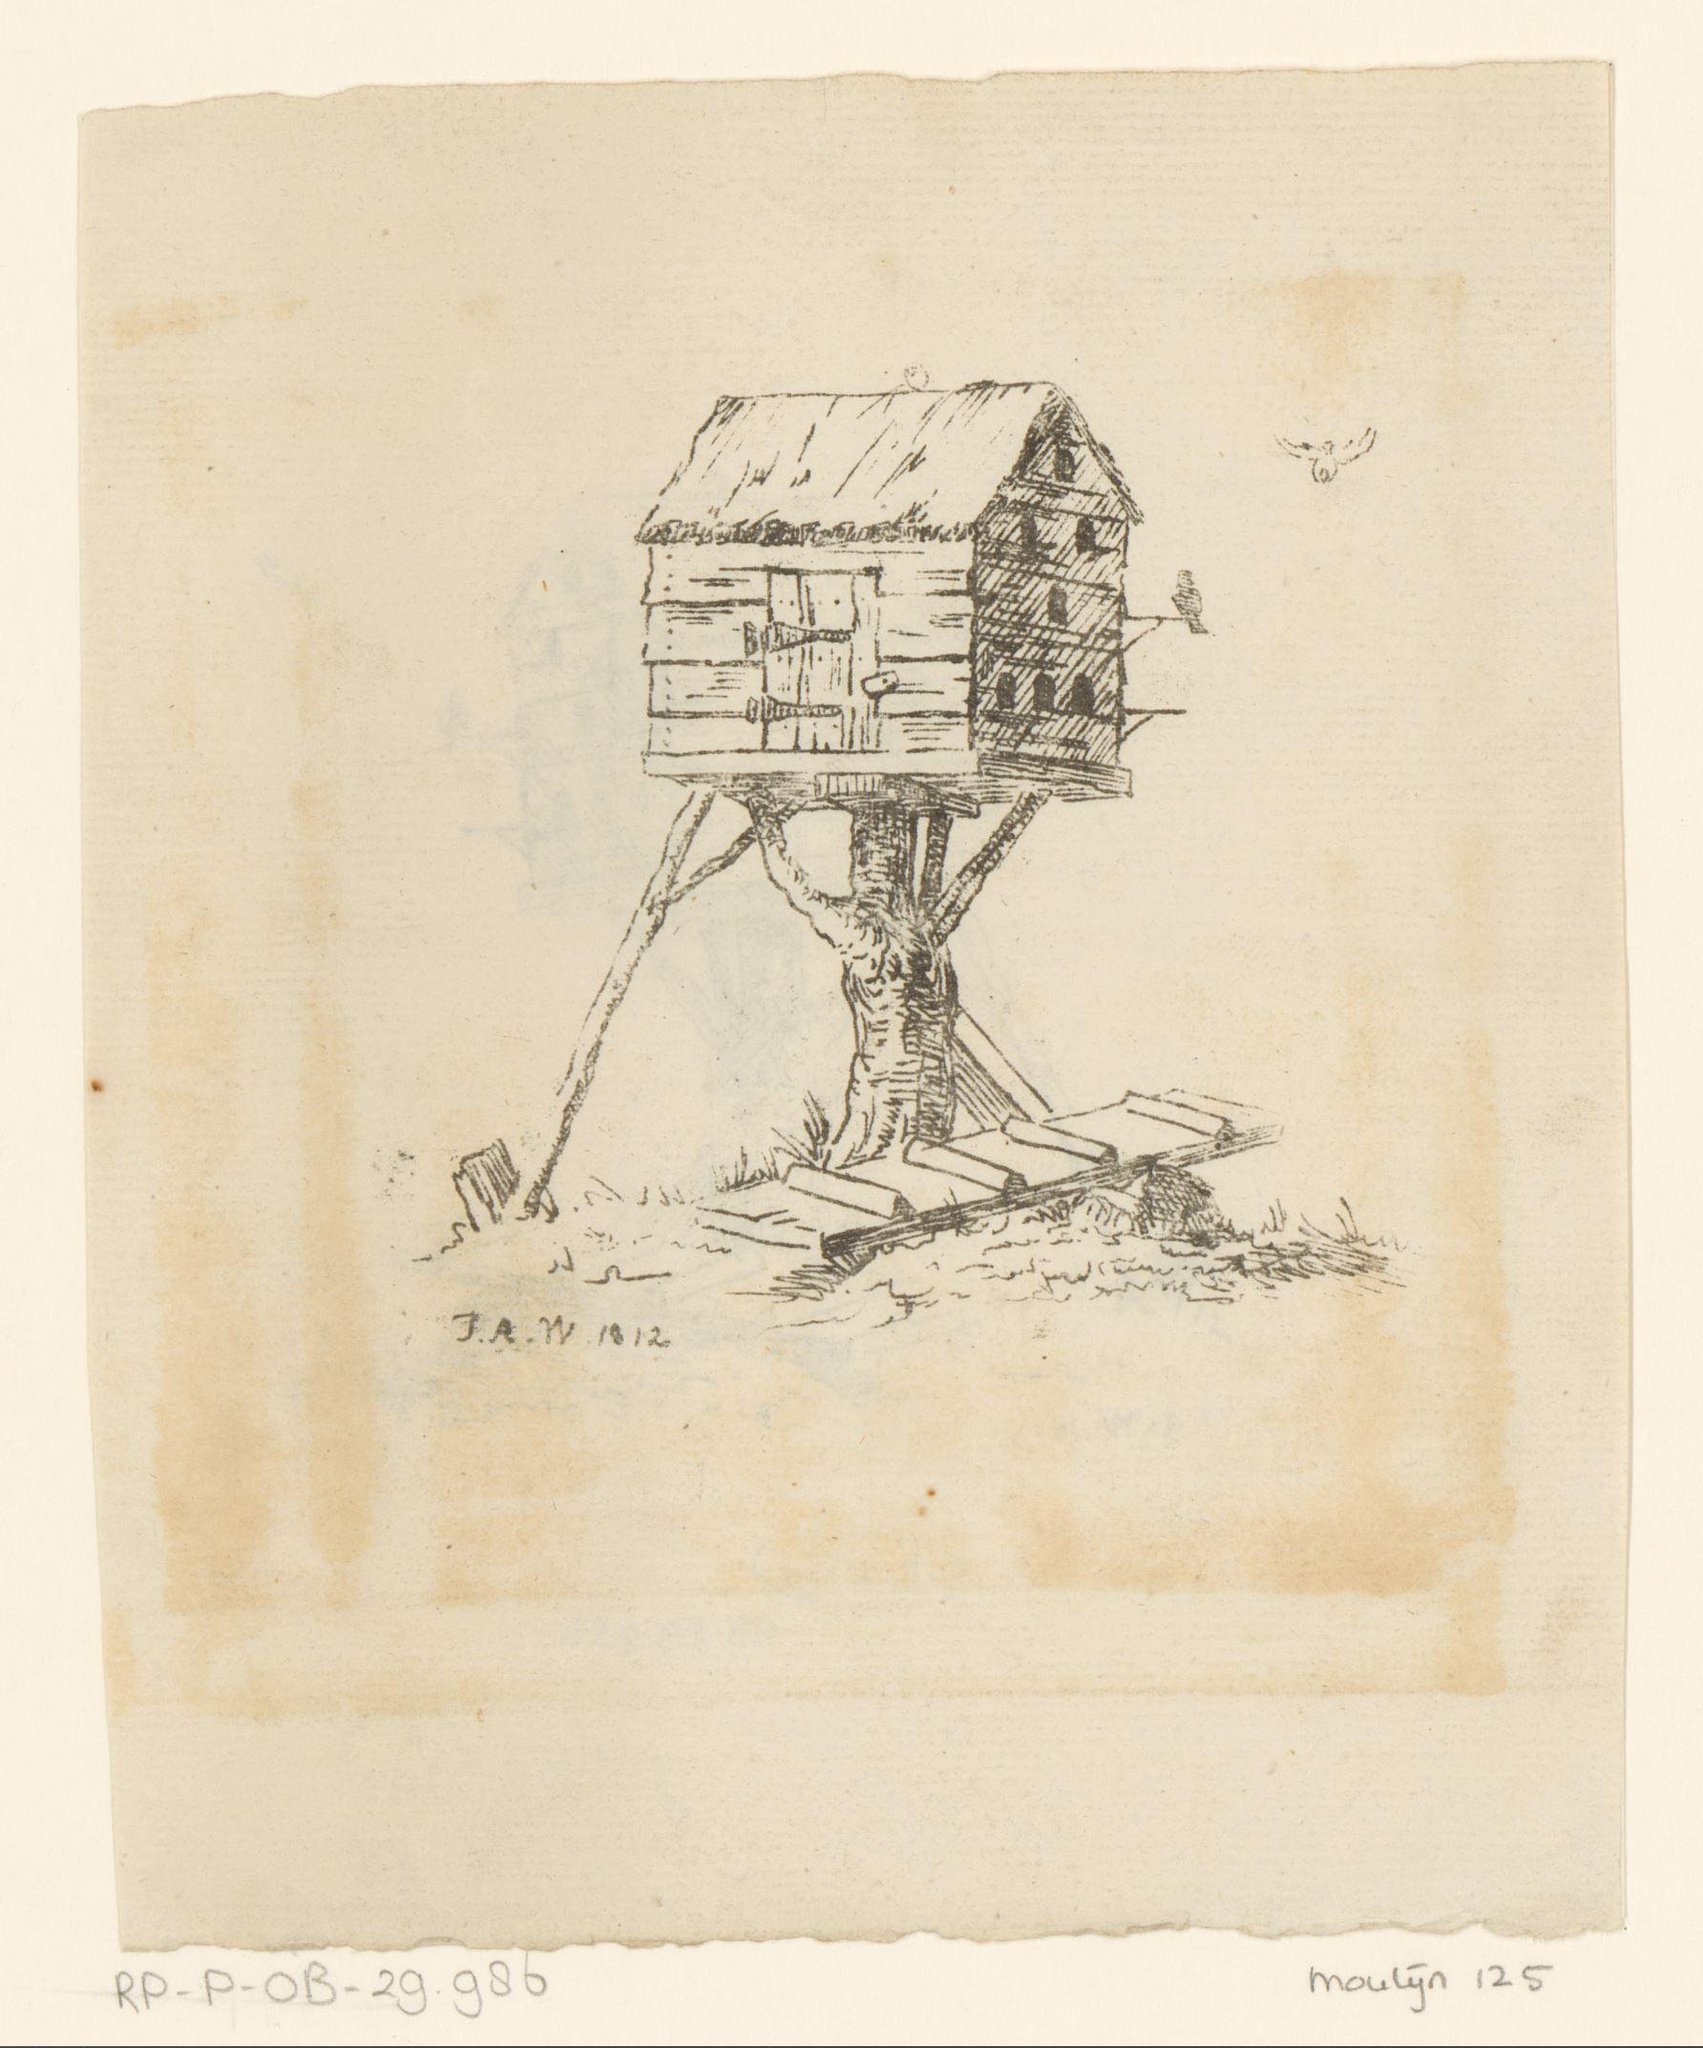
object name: print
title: Boomstronk met duivenhok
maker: jacobus adrianus weiland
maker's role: print maker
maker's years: 1784-1869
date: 1812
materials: paper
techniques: tone lithography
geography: netherlands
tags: dove-cote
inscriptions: date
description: Een duivenhok op boomstronk. Bij het hok zit een duif, een tweede komt aanvliegen.